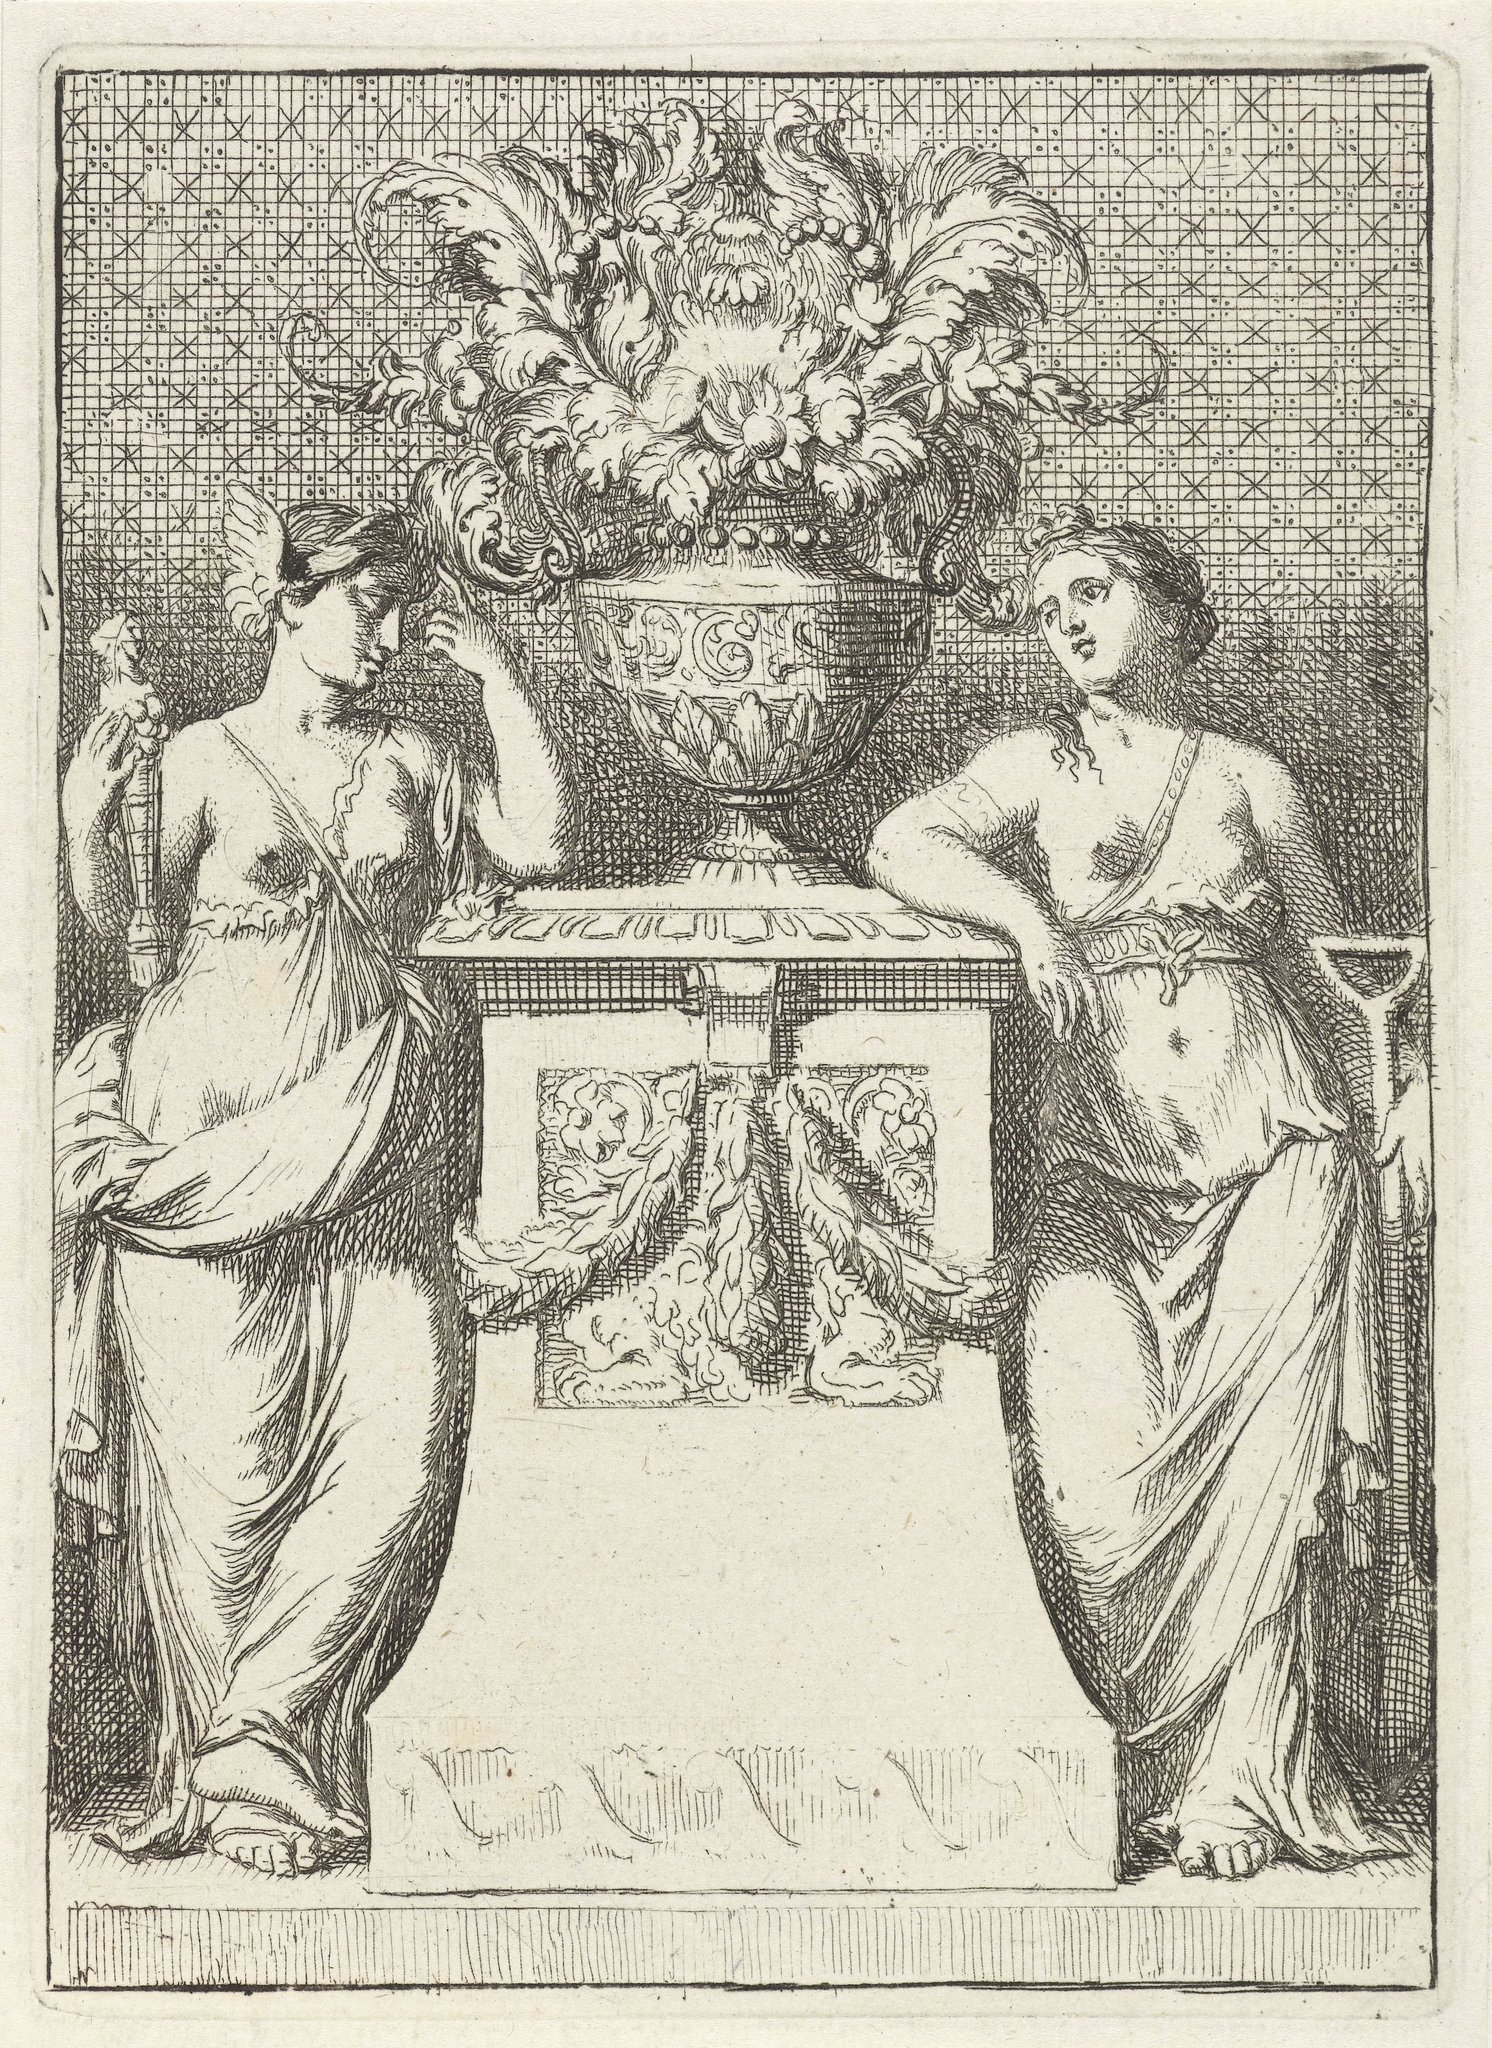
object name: print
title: Bloemenvaas geflankeerd door twee allegorische figuren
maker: gerard de lairesse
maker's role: draughtsman, painter, print maker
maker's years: 1641-1711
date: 1675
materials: paper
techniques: etching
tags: invention, inventiveness; 'inventione' (ripa) (+ personification), flowers in a vase, labour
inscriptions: collector's mark: Lugt 2228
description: Twee allegorische figuren staan links en rechts van een voetstuk waarop een bloemenvaas staat. De linker figuur met vleugeltjes langs haar hoofd en een klein beeld in haar handen stelt de personificatie van inventie voor. De rechter figuur draagt een schop en is mogelijk de personificatie van arbeid.